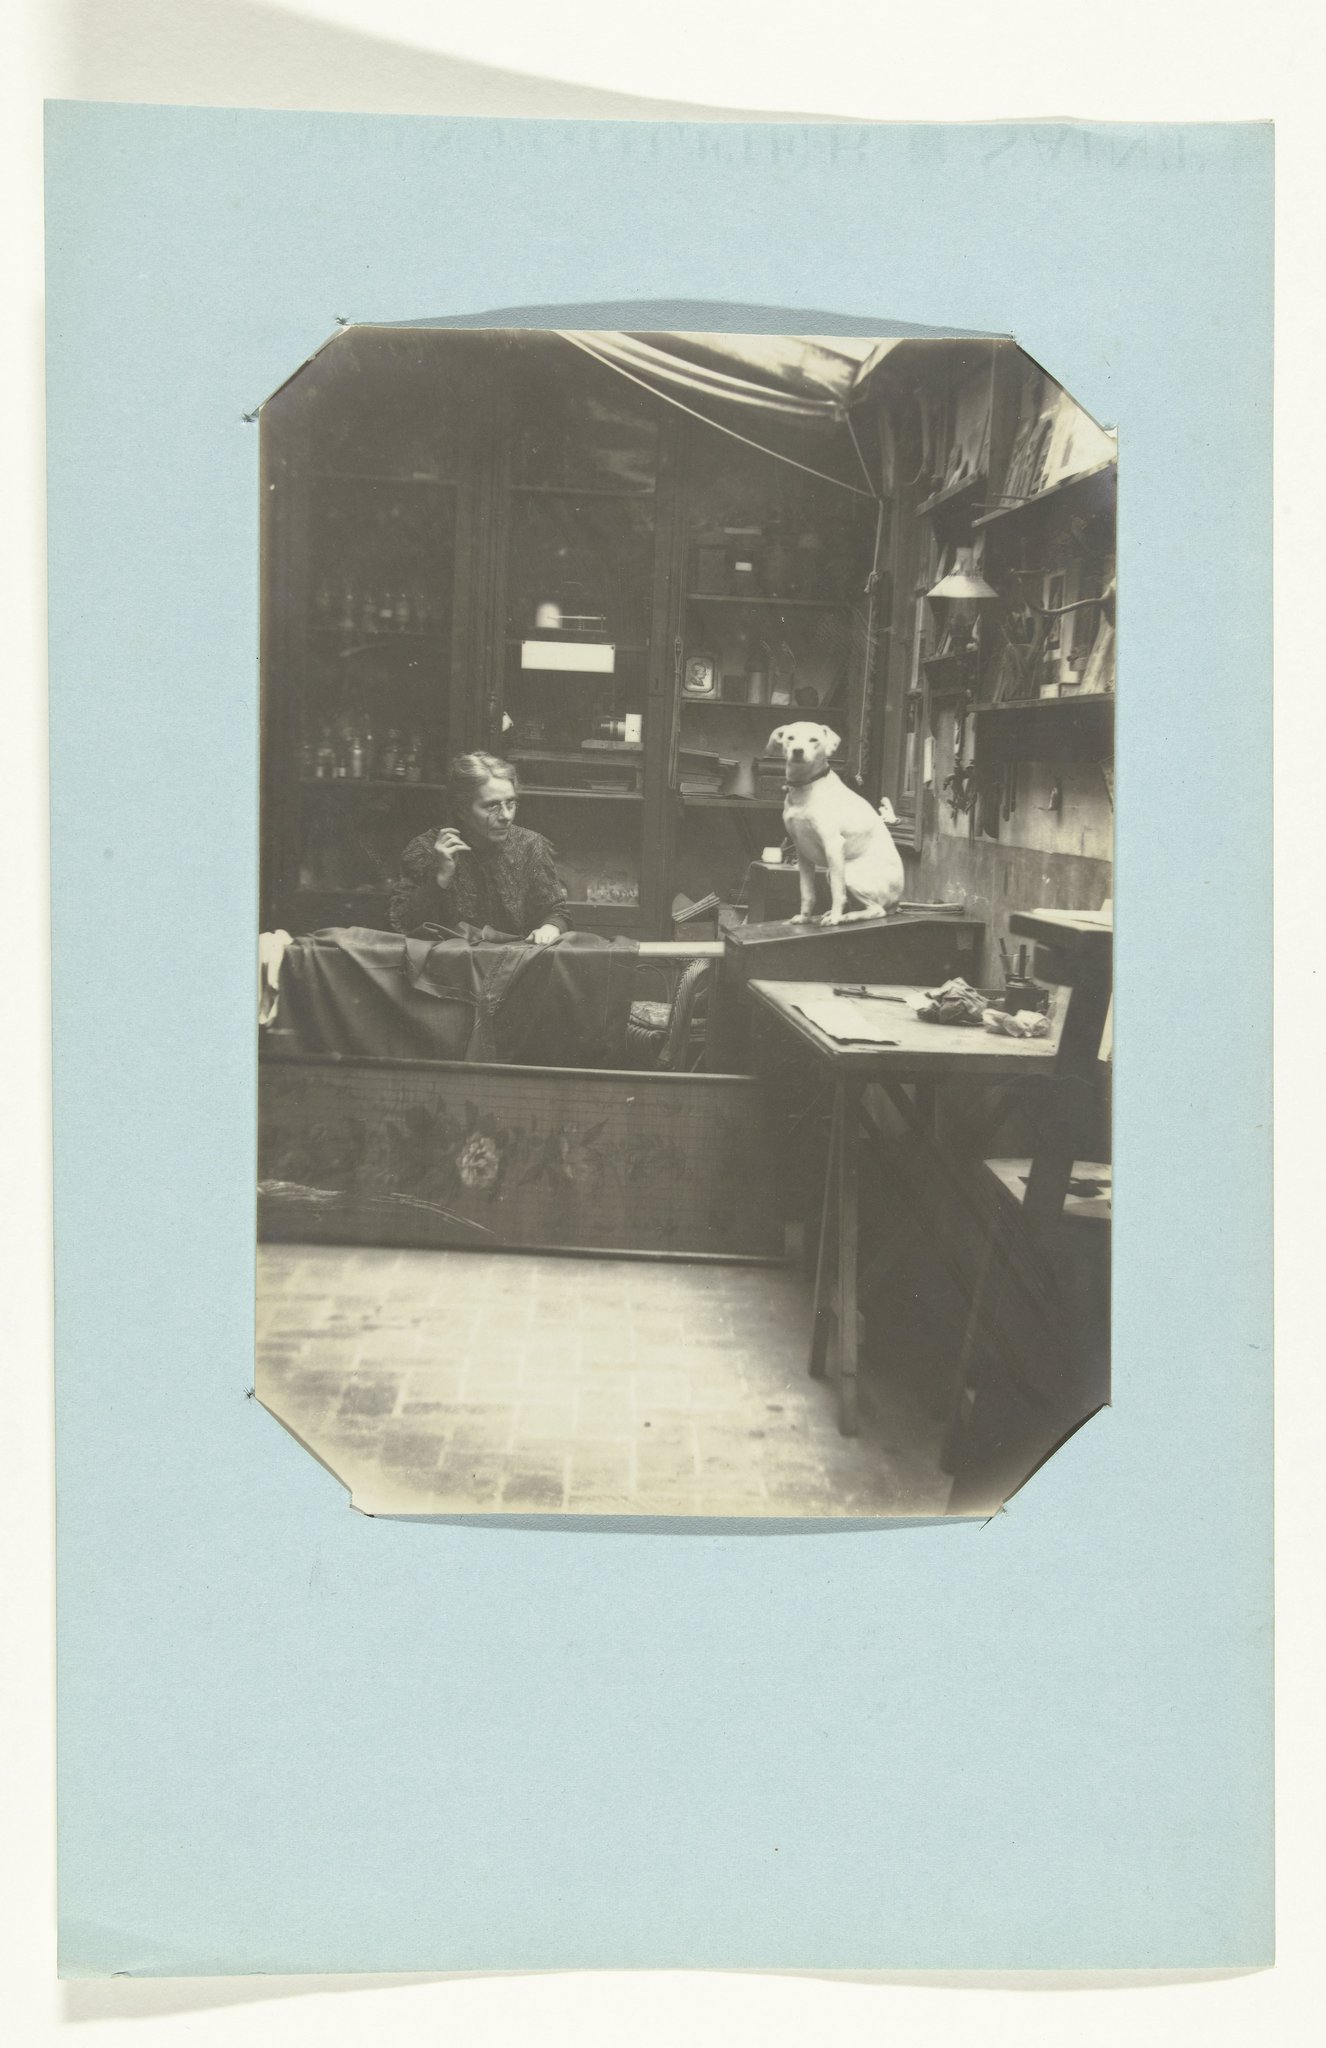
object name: photograph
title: Portret van een onbekende vrouw met naaiwerk en hond in interieur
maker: Anonymous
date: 1891-1908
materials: paper, cardboard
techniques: gelatin silver print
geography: france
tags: historical persons not known by name - bb - woman, sewing, dog, france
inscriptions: watermark: ‘[...]eter Saint’